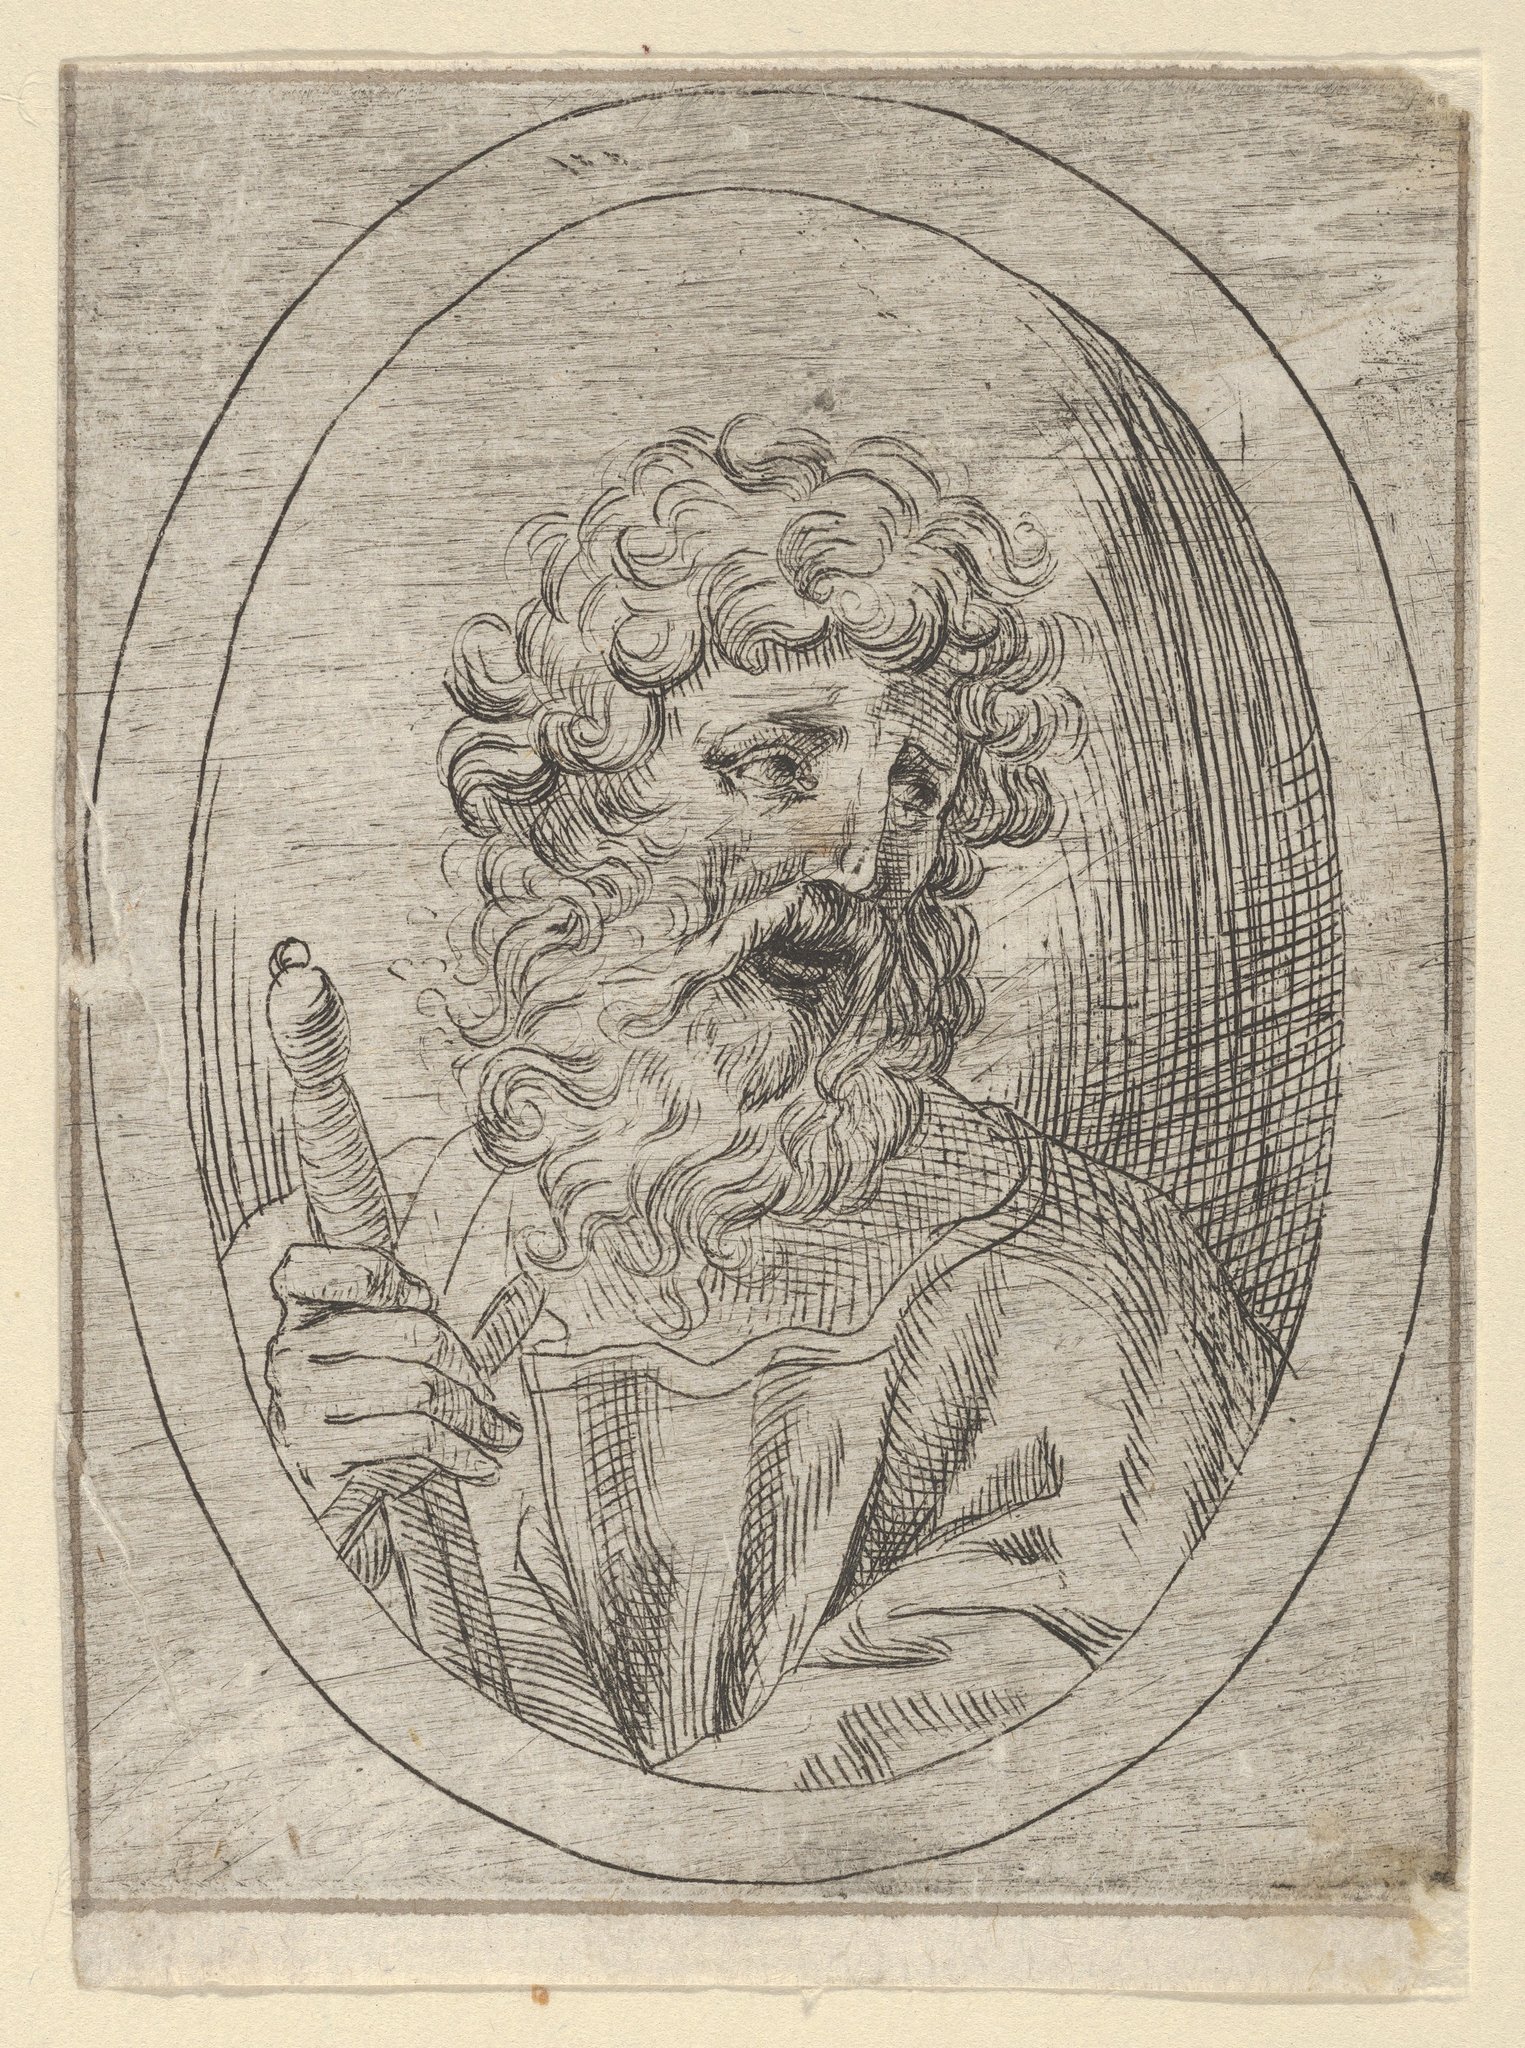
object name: print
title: Saint Paul holding a sword, in an oval frame, from "Christ, the Virgin, and Thirteen Apostles"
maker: anonymous, 17th century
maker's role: artist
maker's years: 1600-1700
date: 1600-1640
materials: ink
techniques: etching, pen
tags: swords,portraits,saint paul